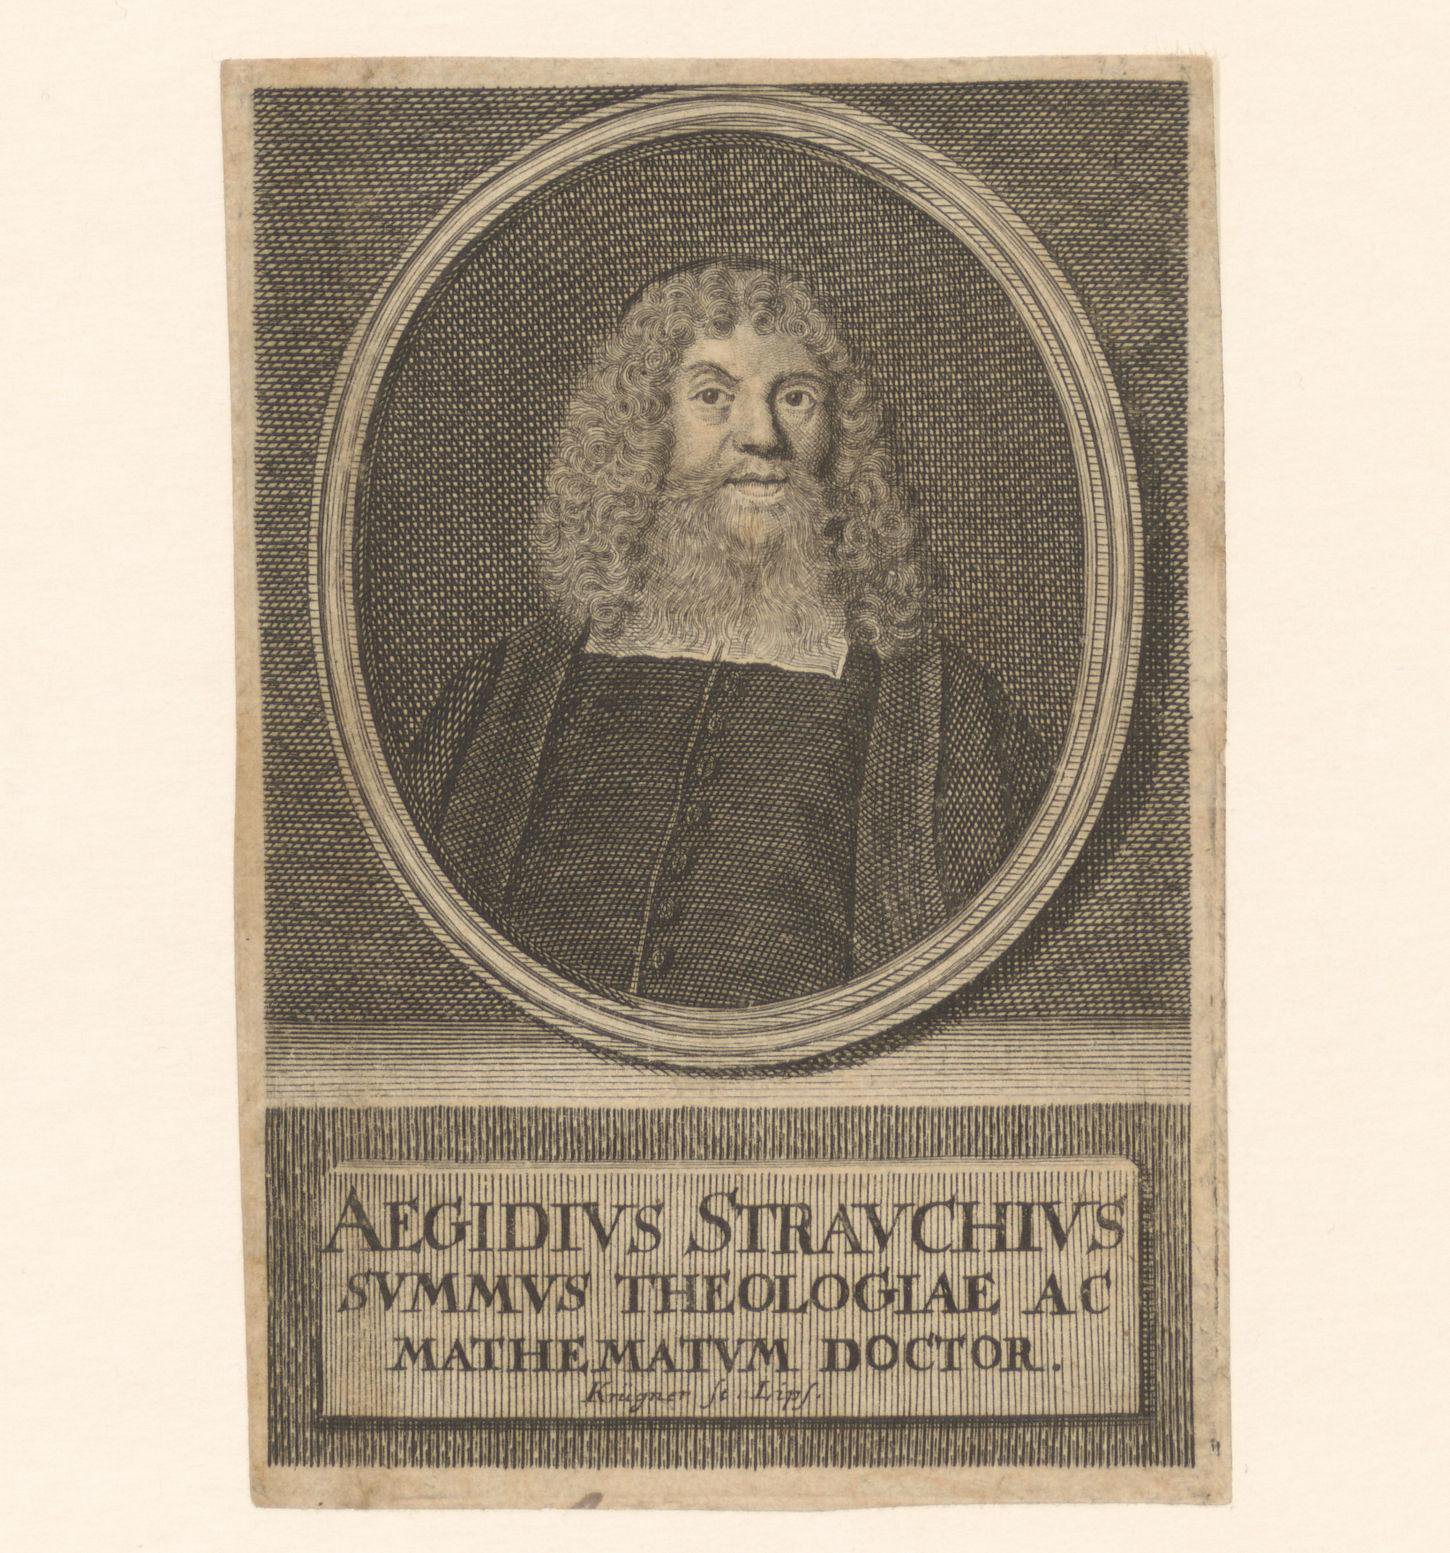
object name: print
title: Portret van Aegidius Strauch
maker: johann gottfried krügner (i)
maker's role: artist, print maker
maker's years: 1684-1769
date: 1694-1769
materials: paper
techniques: engraving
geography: leipzig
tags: theologian, historical persons, mathematics (+ portrait of scholar, scientist)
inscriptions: collector's mark: Lugt 2228